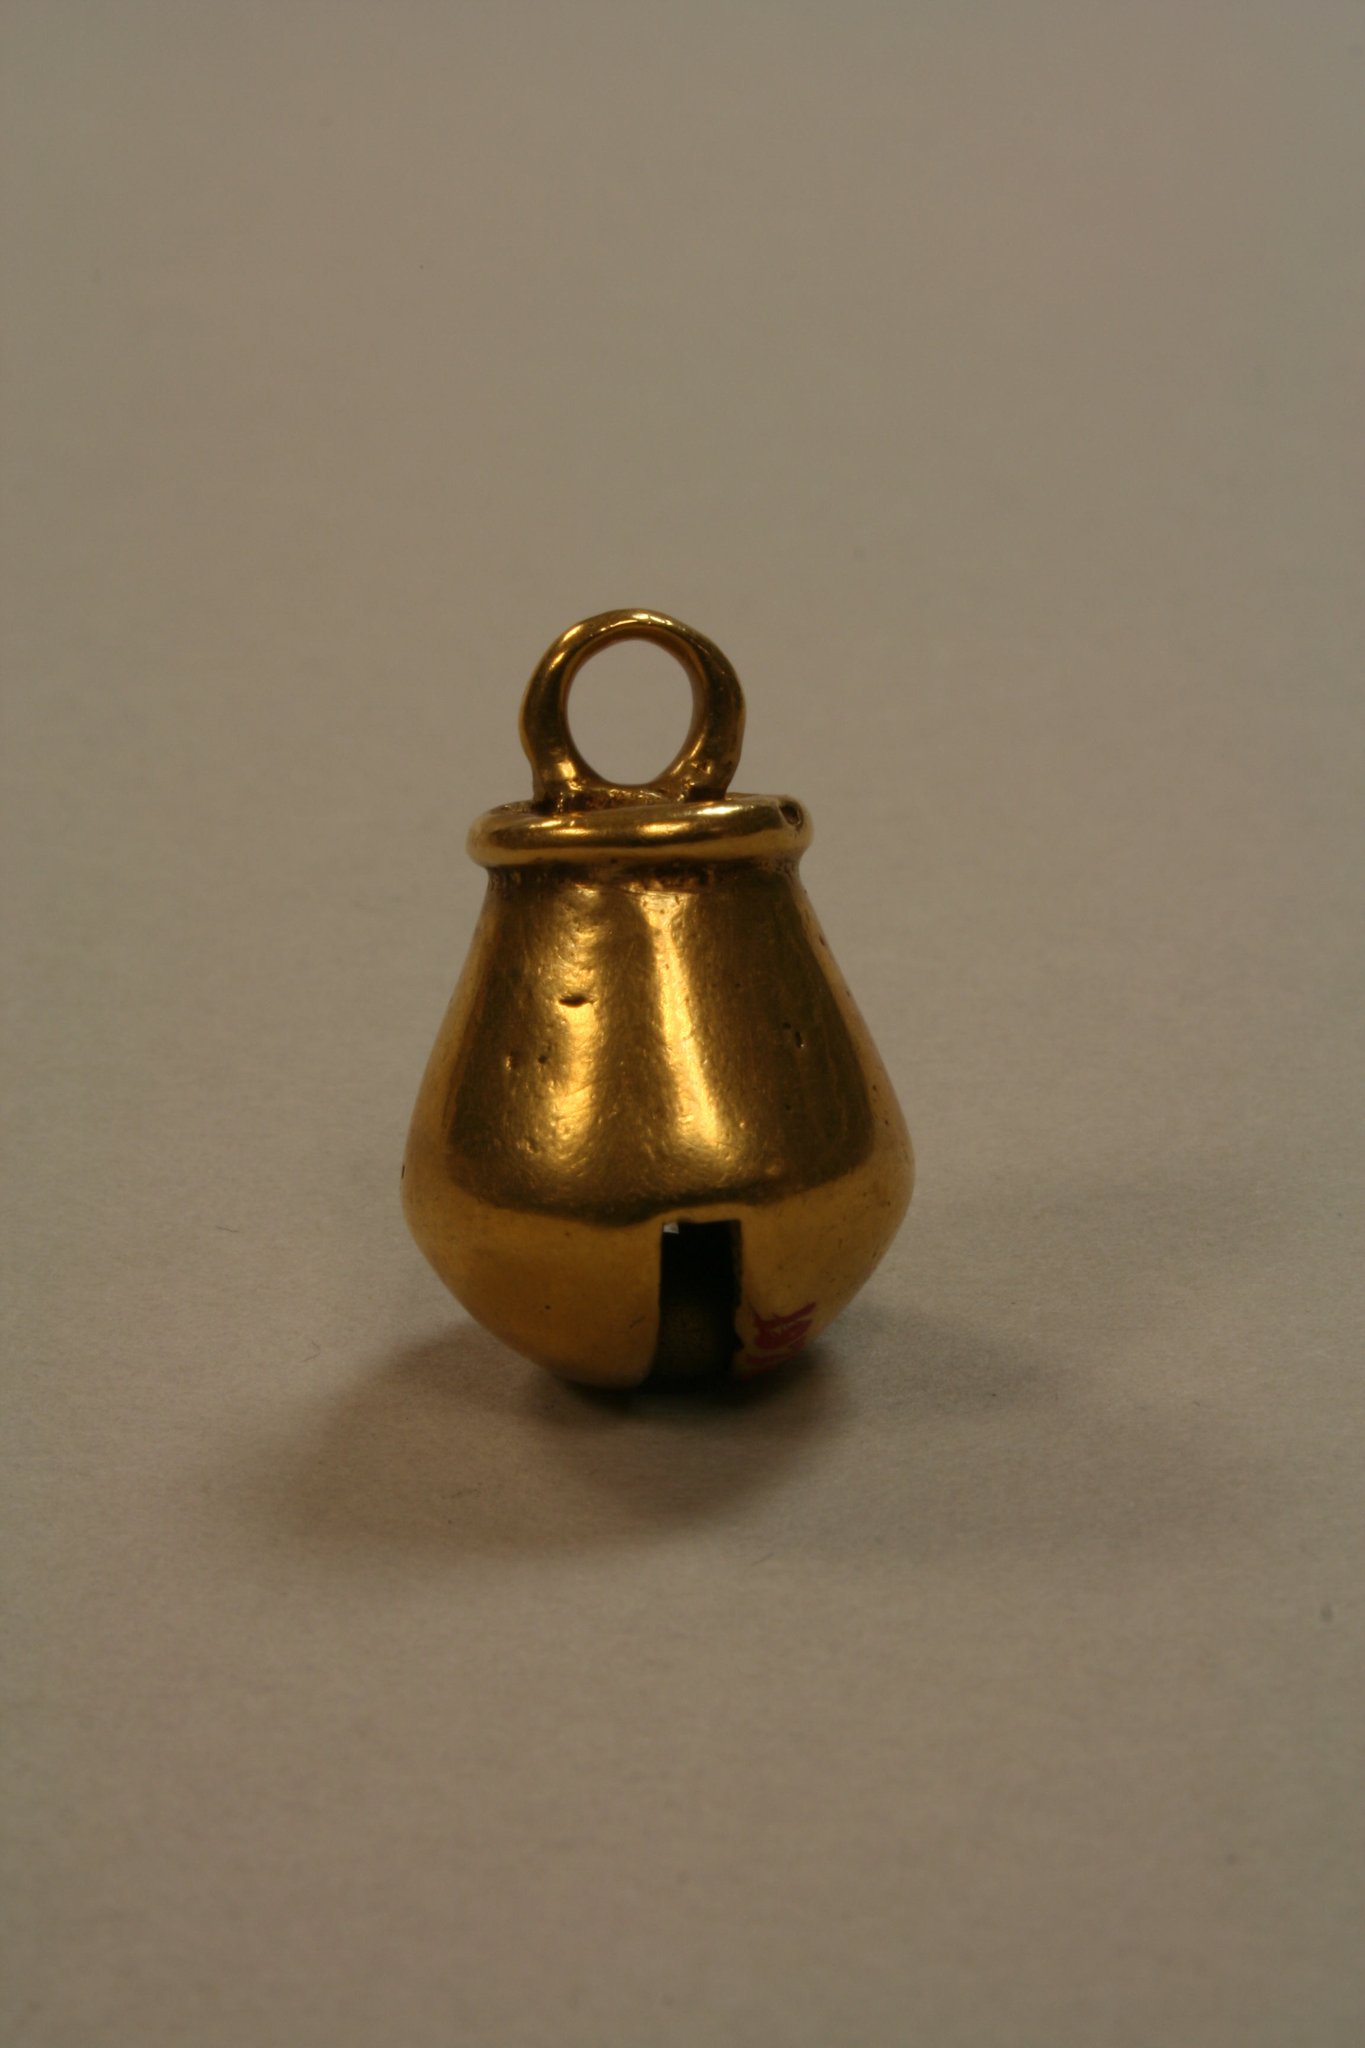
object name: bell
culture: greater nicoya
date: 500-1520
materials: gold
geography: costa rica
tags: musical instruments